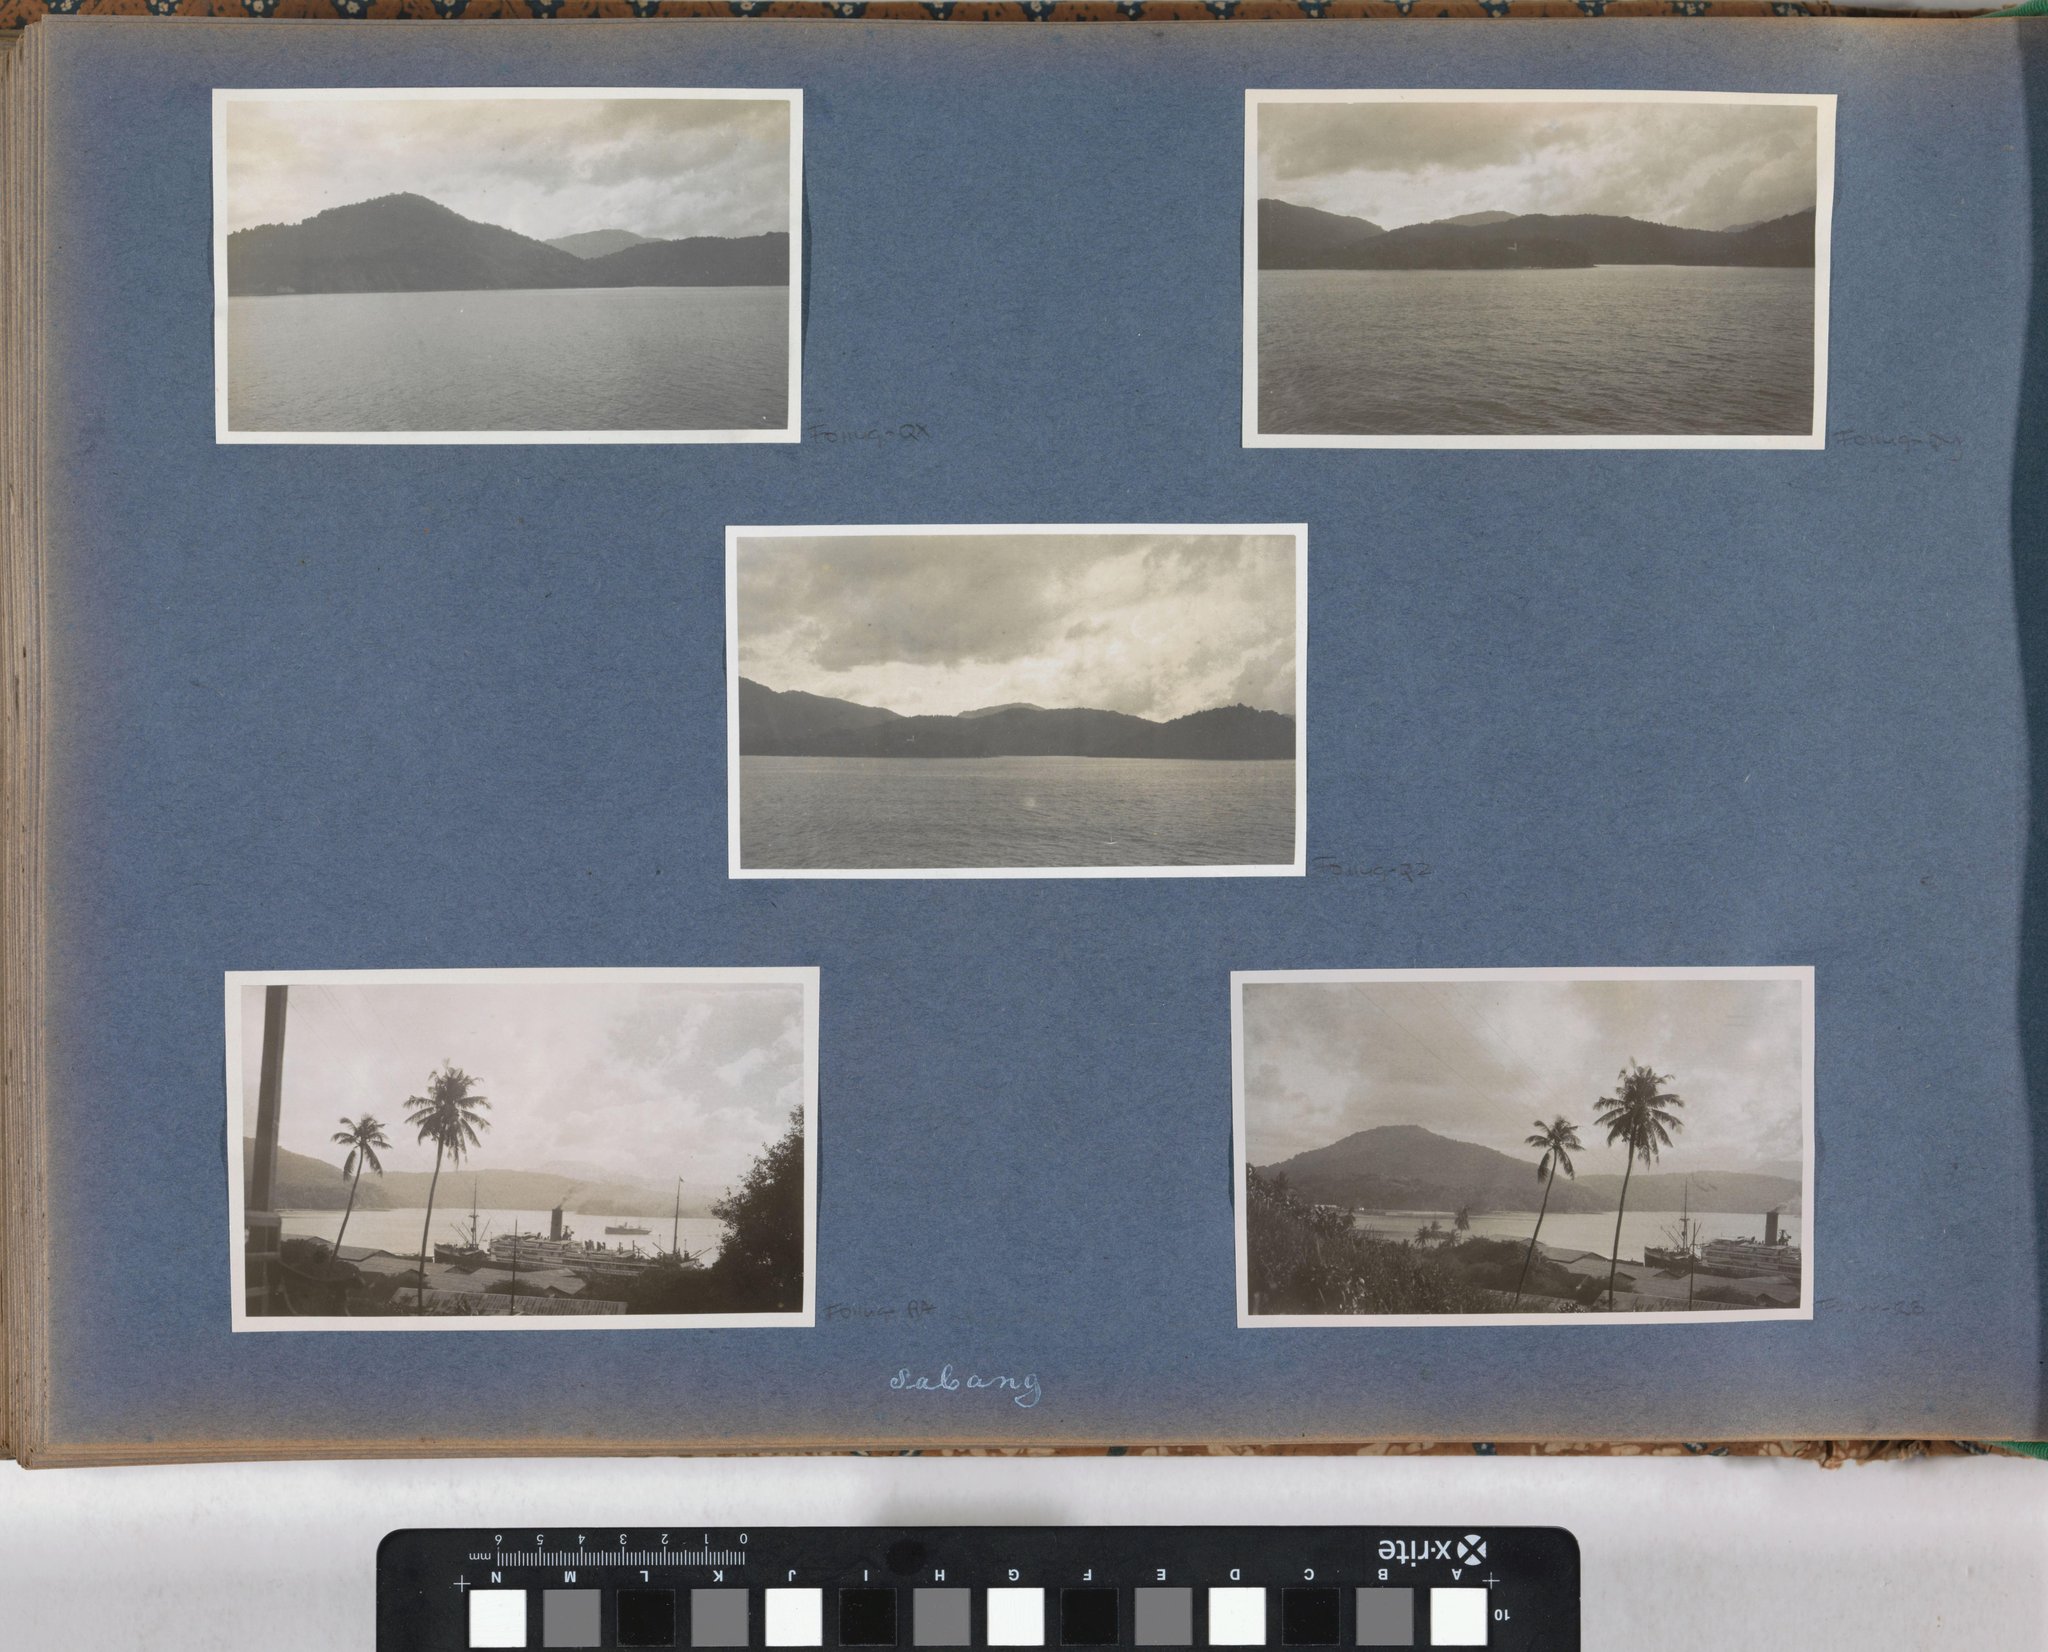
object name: album leaf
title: Meer met bergen te Sabang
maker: Anonymous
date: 1900-1920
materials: paper, photographic support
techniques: gelatin silver print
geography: sabang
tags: lake, mountains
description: Onderdeel van reisalbum met foto's van bedrijvigheid en bezienswaardigheden op Sumatra en Java en van de reis naar en van Nederlands-Indië.